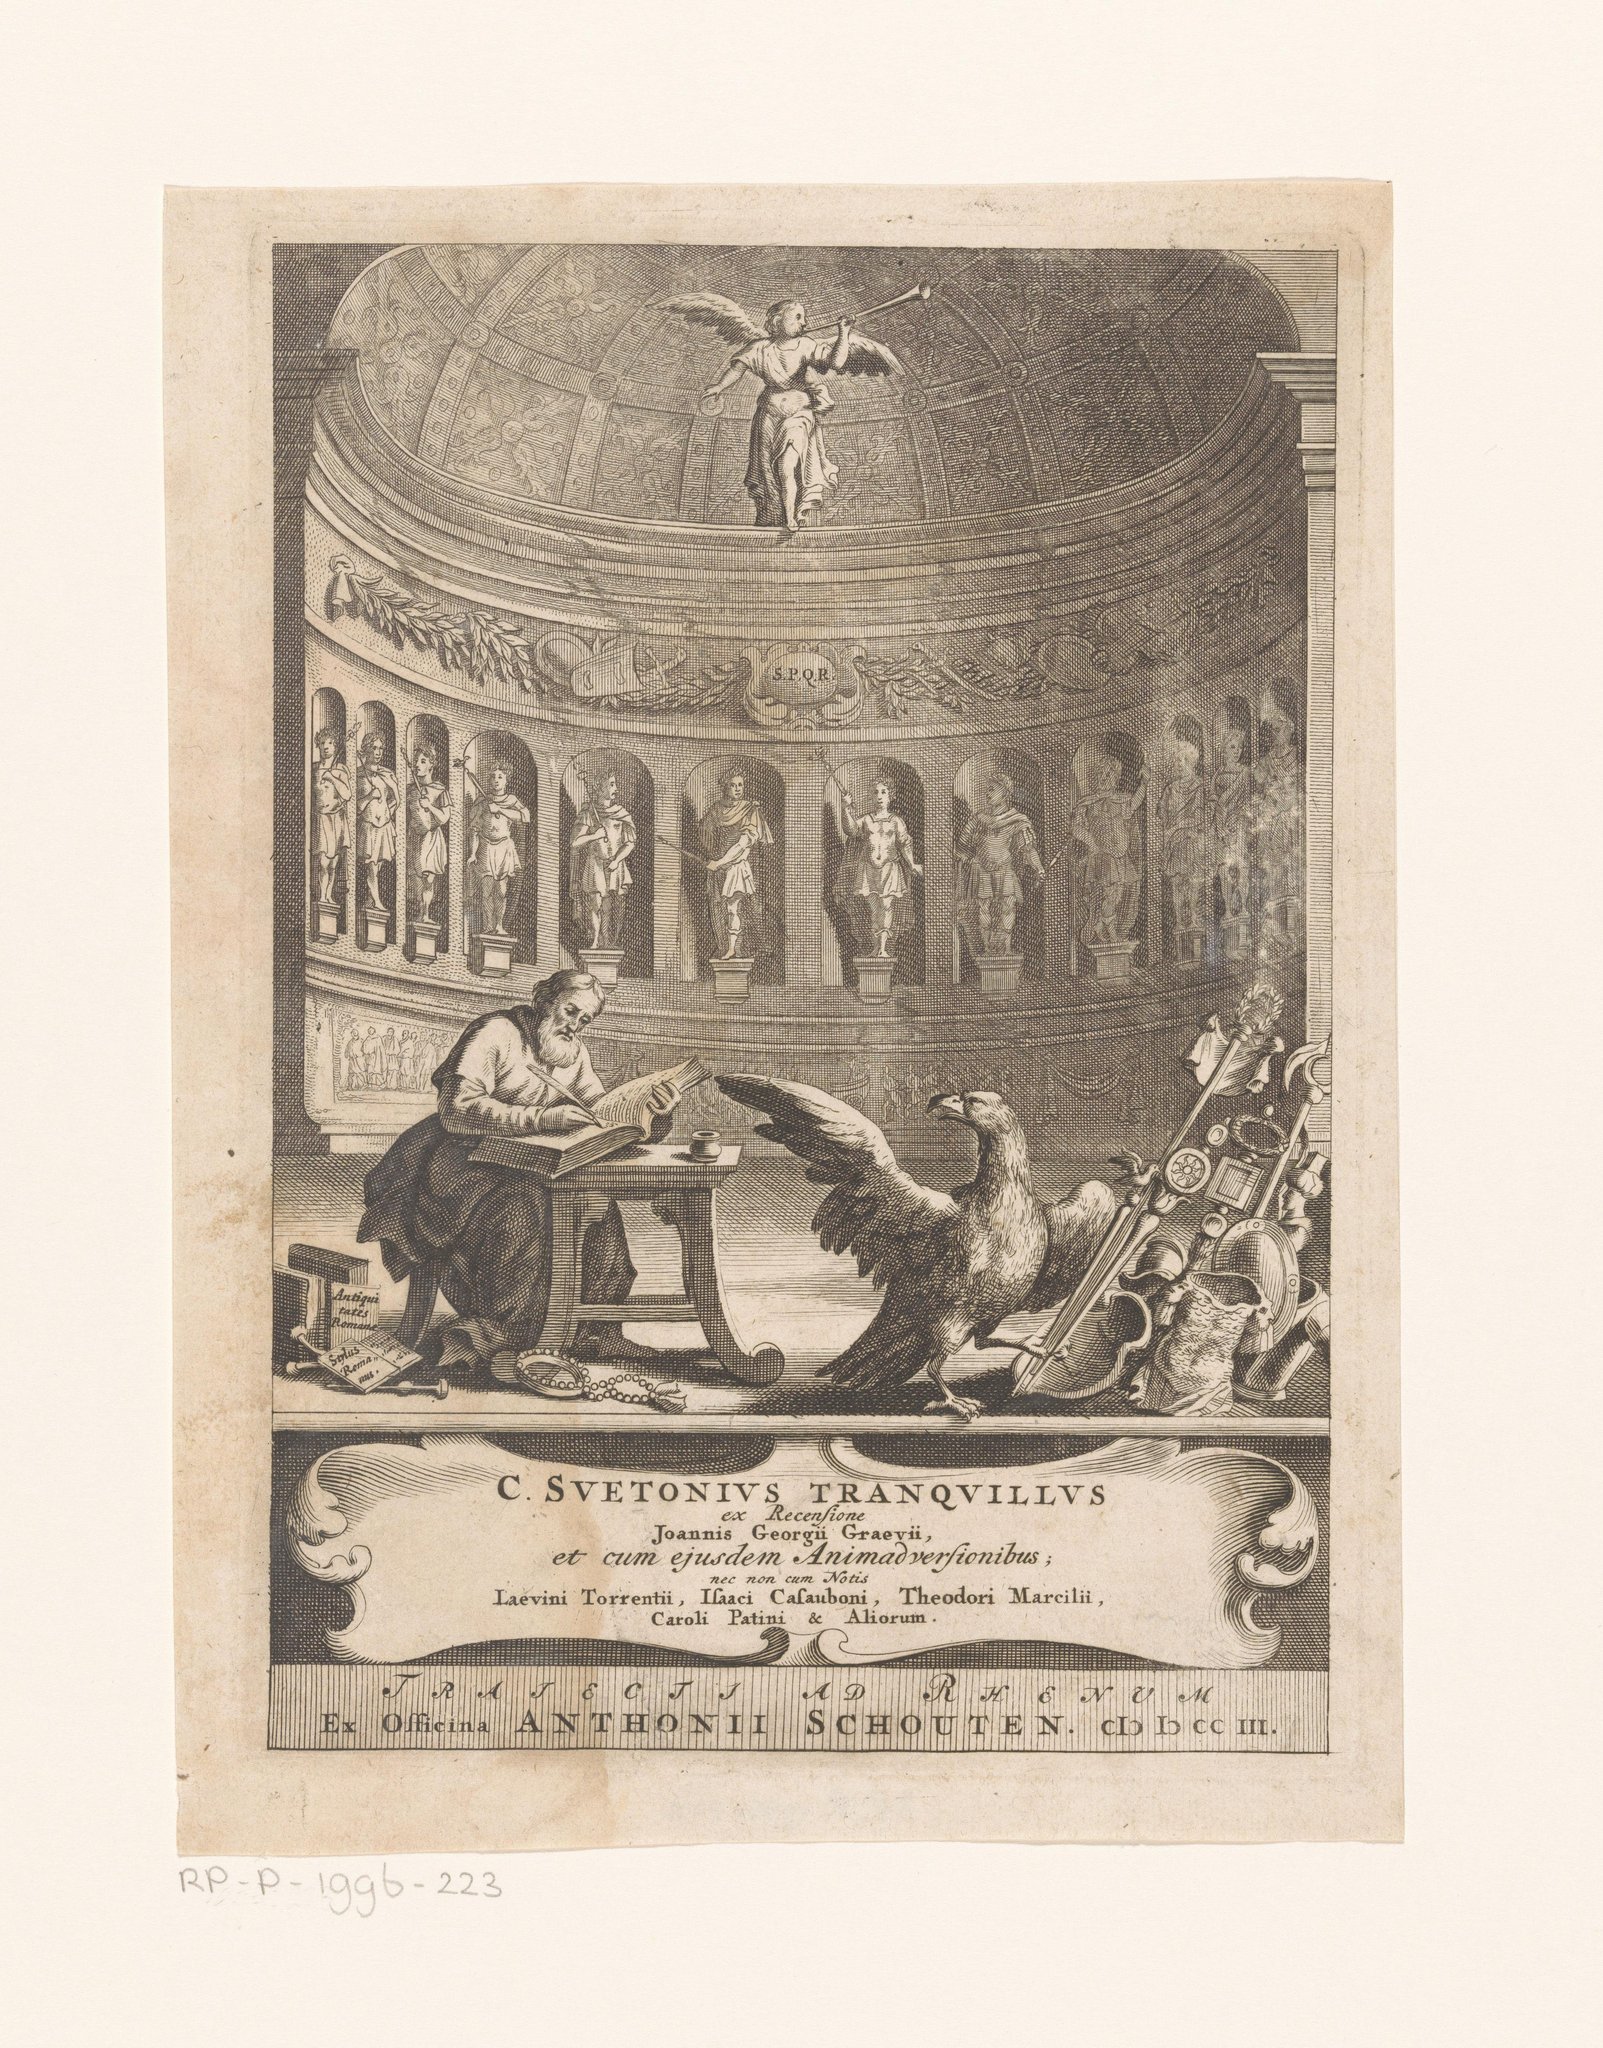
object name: print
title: Suetonius in koepelgebouw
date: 1703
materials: paper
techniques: engraving, etching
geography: utrecht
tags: other architectural details (cupola), writer, poet, author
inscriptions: collector's mark: Lugt 2760, collector's mark: Lugt 2228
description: Een man, mogelijk Gaius Suetonius Tranquillus, zit aan een tafel en schrijft in een boek. Rechts een adelaar met wapentrofeeën. In de achtergrond een koepel met beelden van antieke helden in nissen. Daarboven Fama blazend op een bazuin.